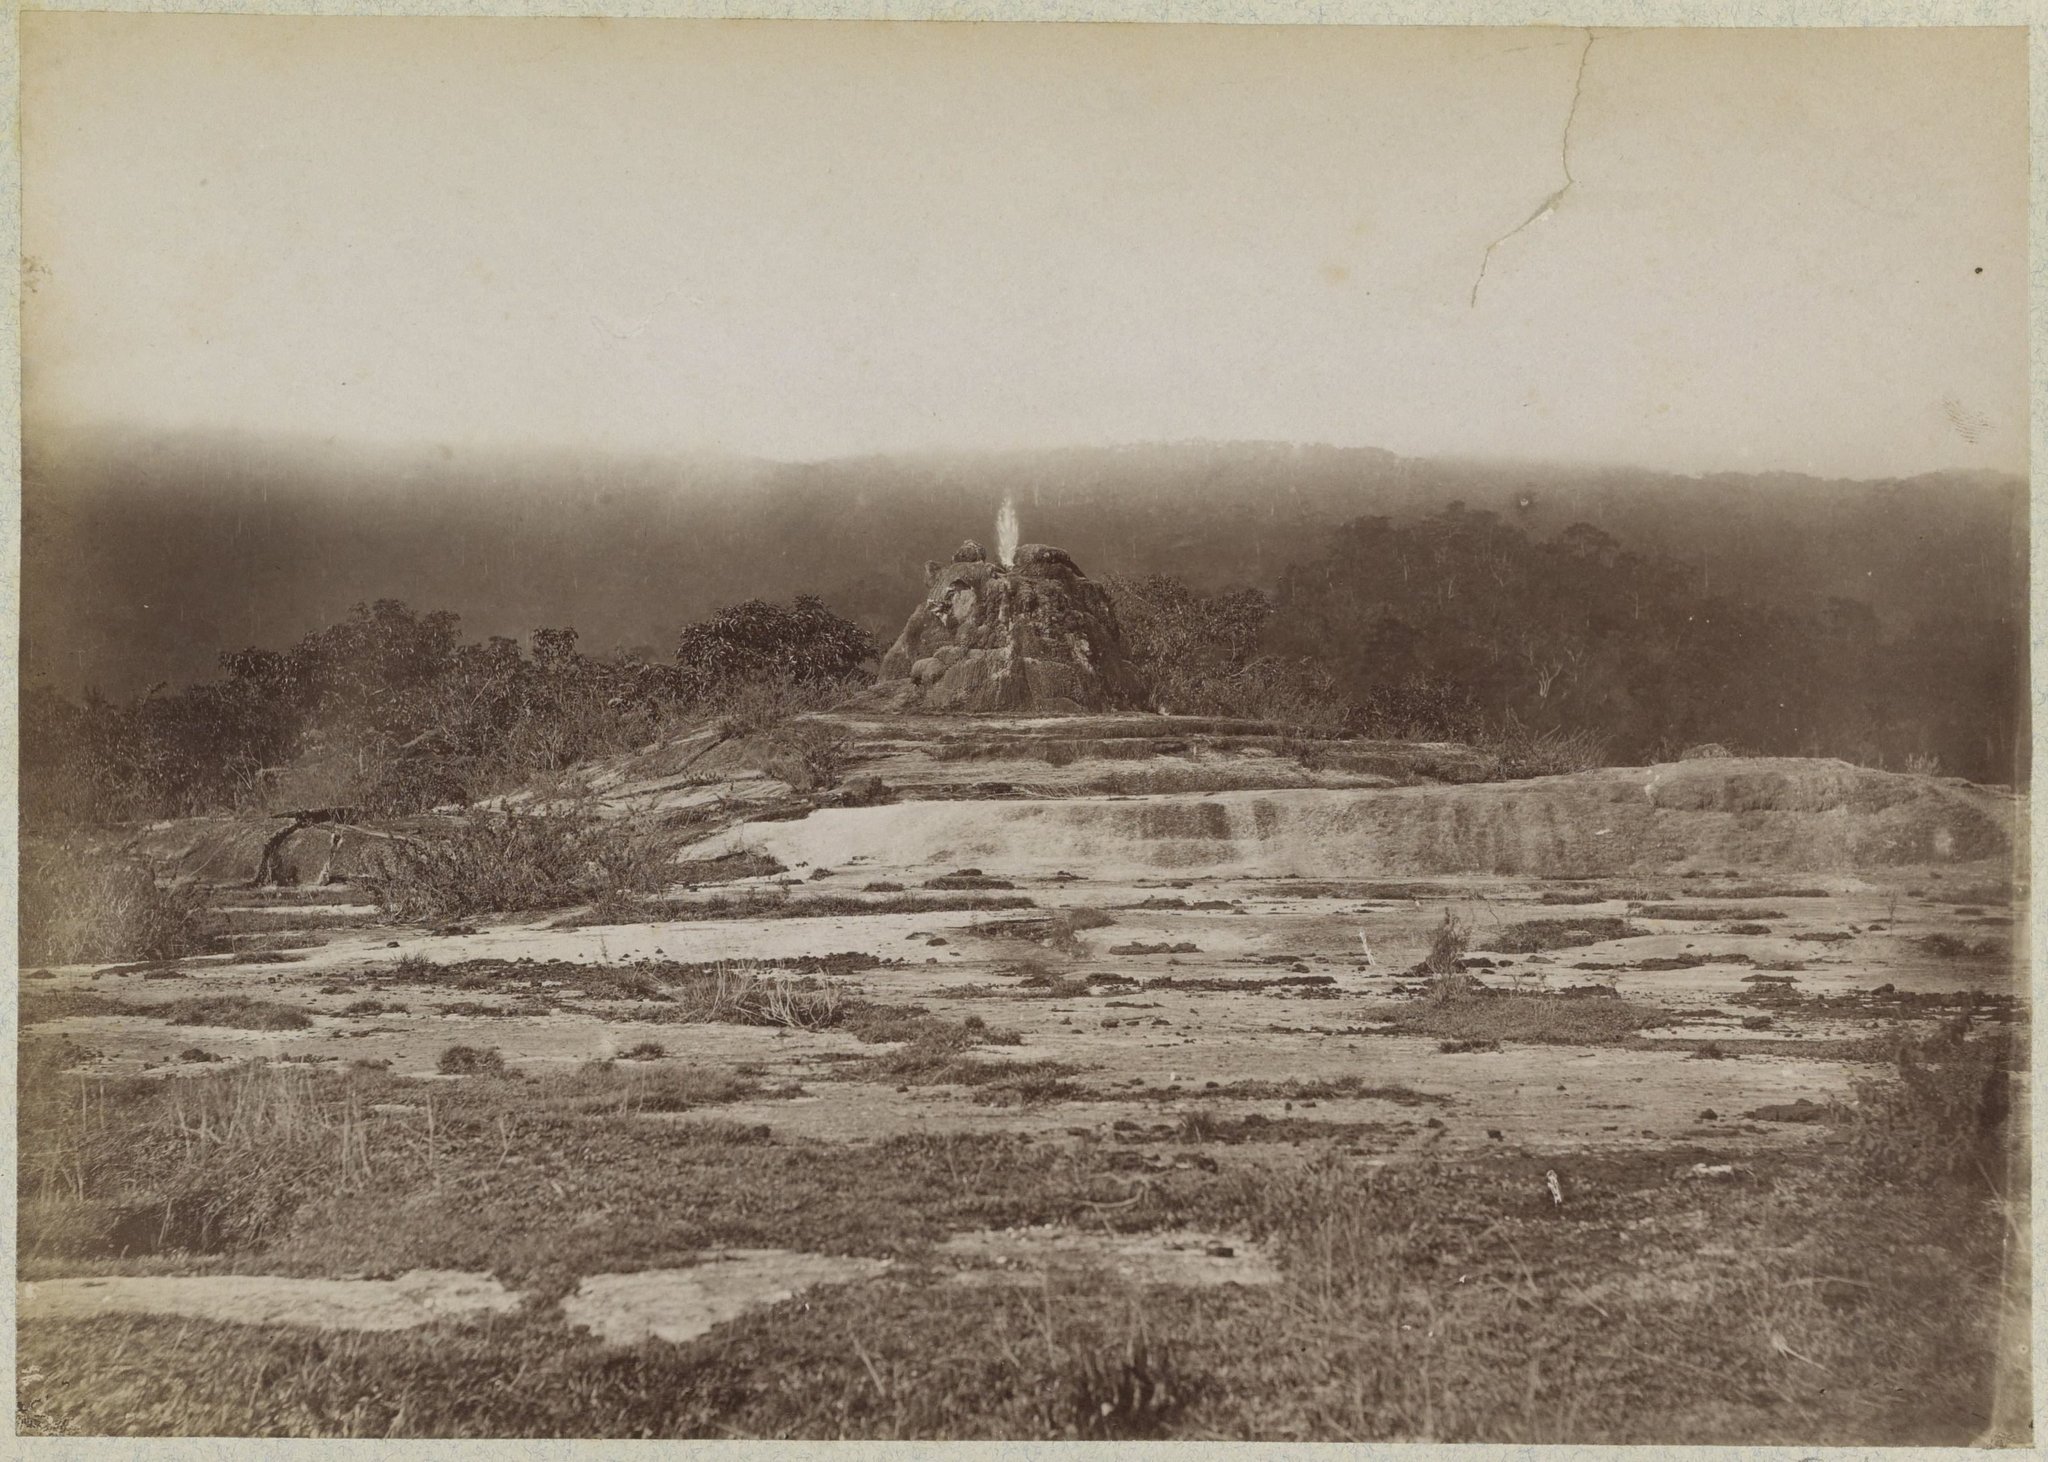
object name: photograph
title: Vulkanisch landschap met rookpluim, vermoedelijk op de Filipijnen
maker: Anonymous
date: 1870-1891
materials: paper, photographic support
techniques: albumen print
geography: philippines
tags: eruption (of volcano), philippines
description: Onderdeel van Fotoalbum van een reis naar Manilla.